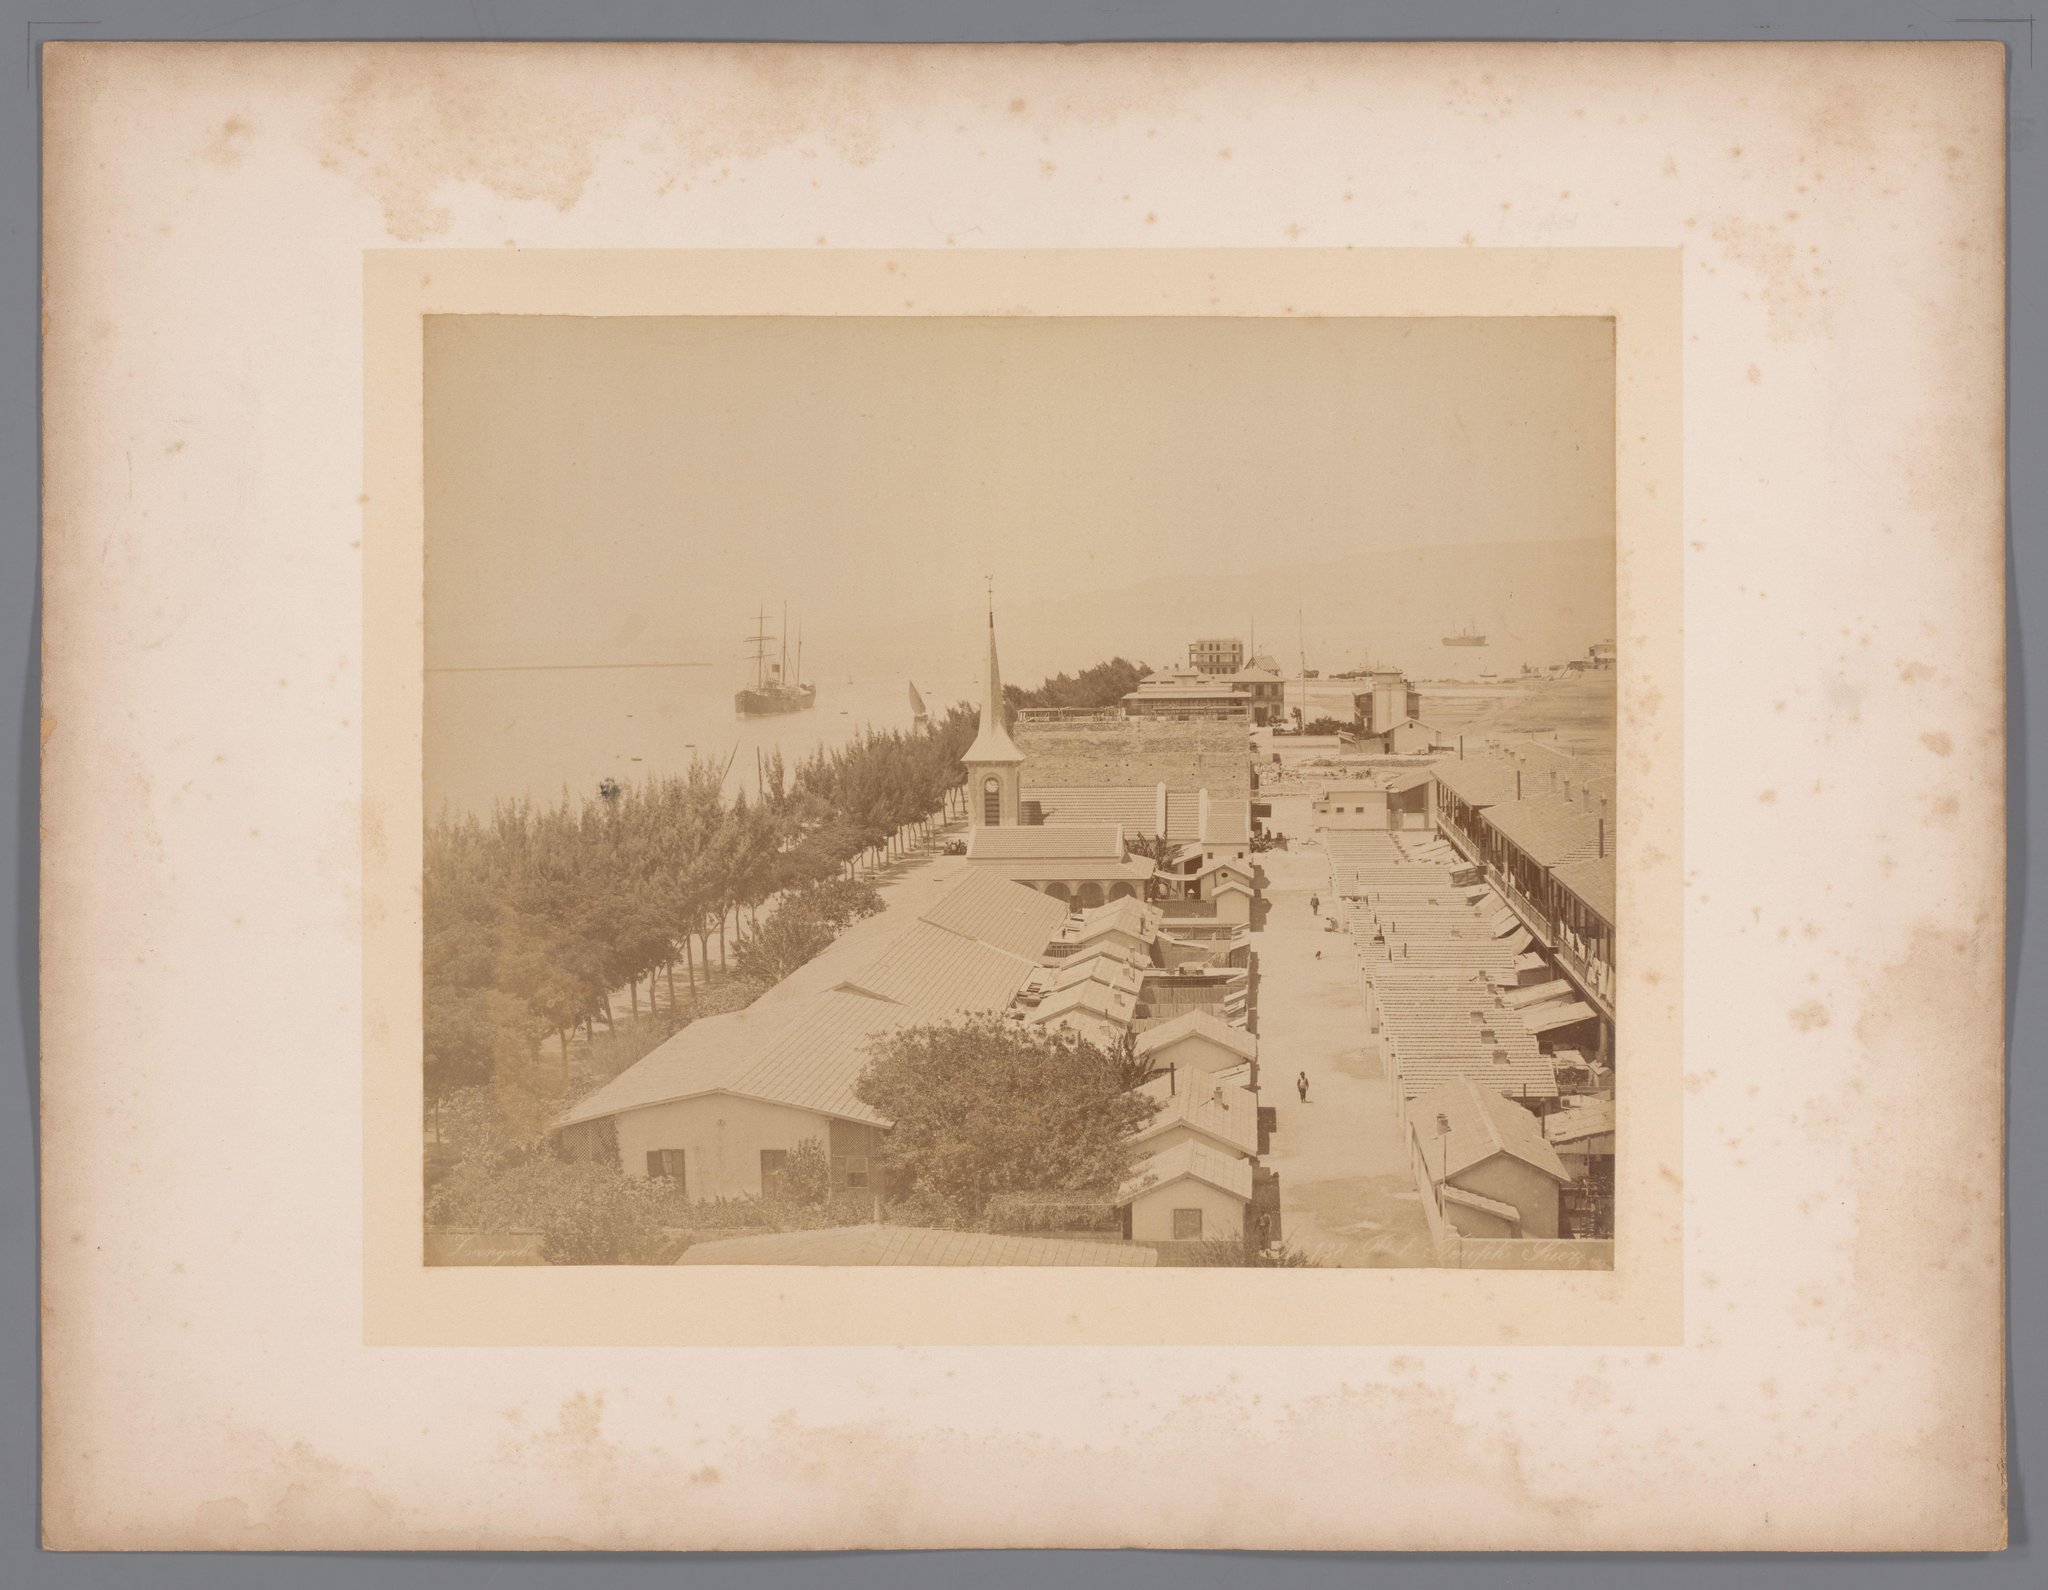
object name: photograph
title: Port Tewfik Suez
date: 1870-1910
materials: cardboard, paper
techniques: albumen print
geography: port tewfik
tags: city-view in general; 'veduta', canal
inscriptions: number: ‘No. 138’, inscription: ‘Port Tewfik Suez/ foto Zangaki’